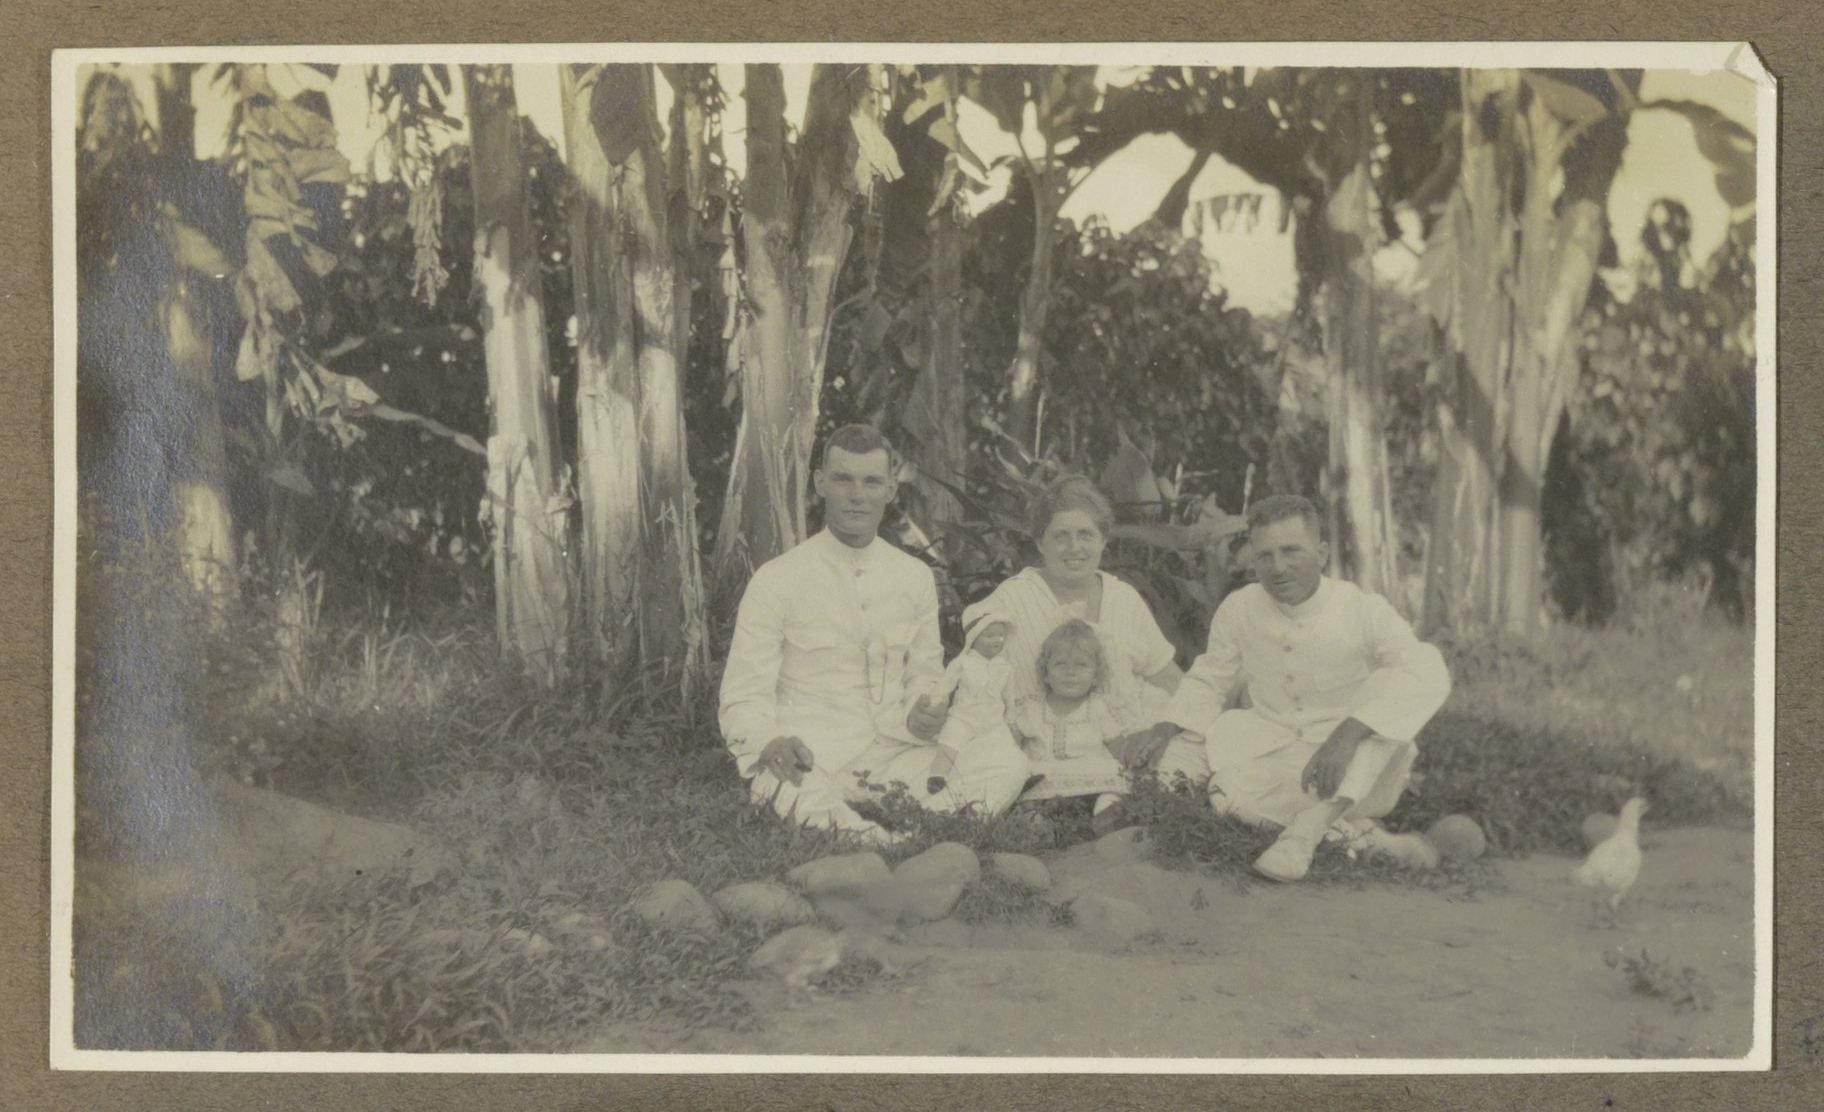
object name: photograph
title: Leden van de familie Janschen zittend op een erf in Medan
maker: Anonymous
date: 1920-1930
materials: photographic support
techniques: gelatin silver print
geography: medan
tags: family life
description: Onderdeel van fotoalbum van een onbekende Nederlandse familie met opnames van Suriname, Europa en Nederlands-Indië.